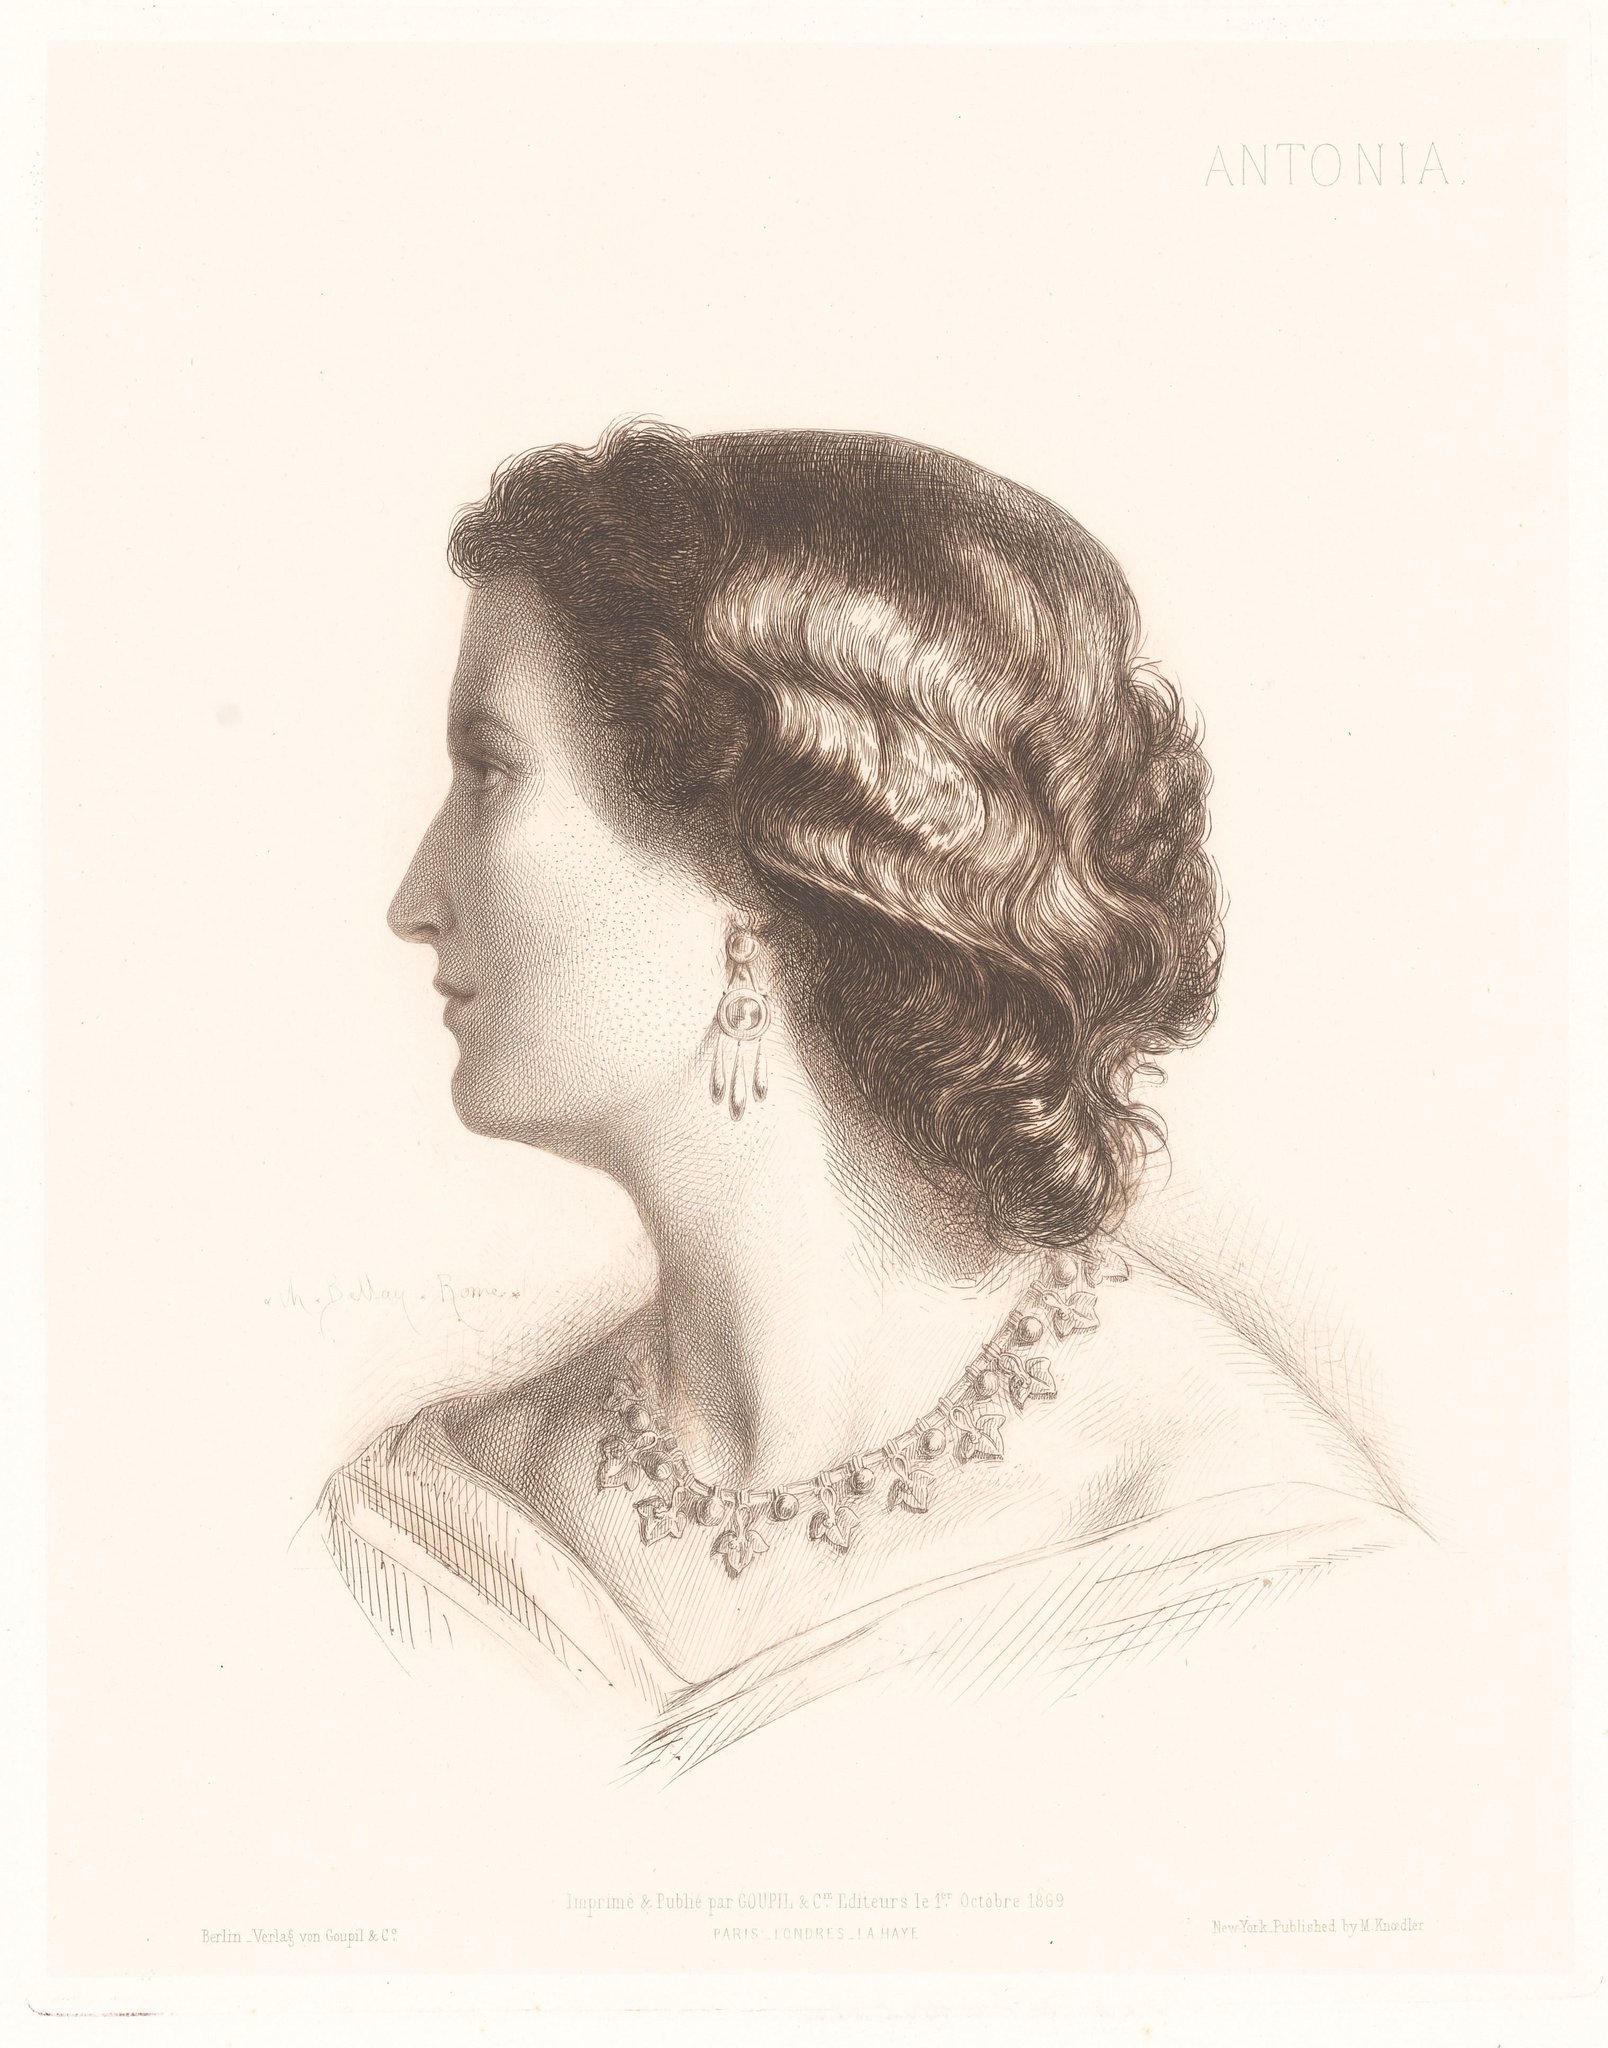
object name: print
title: Portretten van Italiaanse vrouwen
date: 1869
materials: paper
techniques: etching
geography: paris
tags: historical persons, anonymous historical person portrayed - bb - woman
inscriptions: collector's mark: Lugt 2228